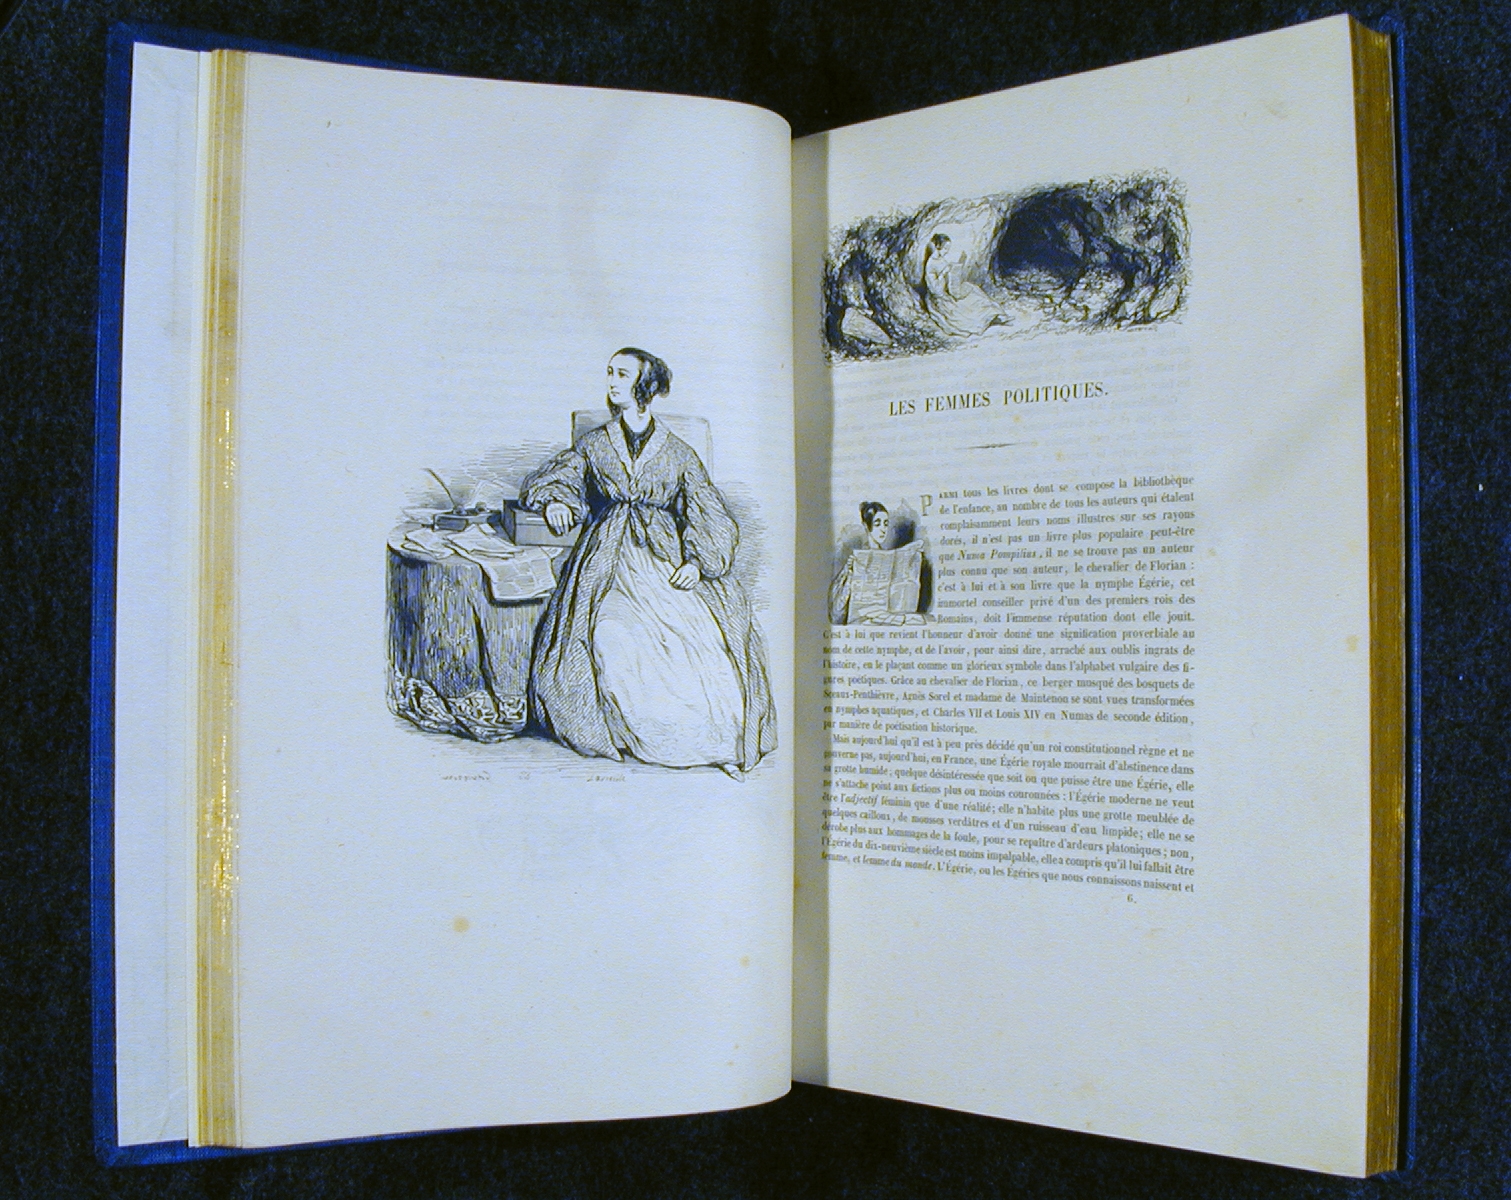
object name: book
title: Les Français Peints par Eux-Mêmes. Tome 1-5. Province Tome 1-3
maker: henri-léon curmer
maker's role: publisher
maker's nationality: french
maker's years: 1801-1870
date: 1840-1842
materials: wood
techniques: engraving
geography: france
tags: women